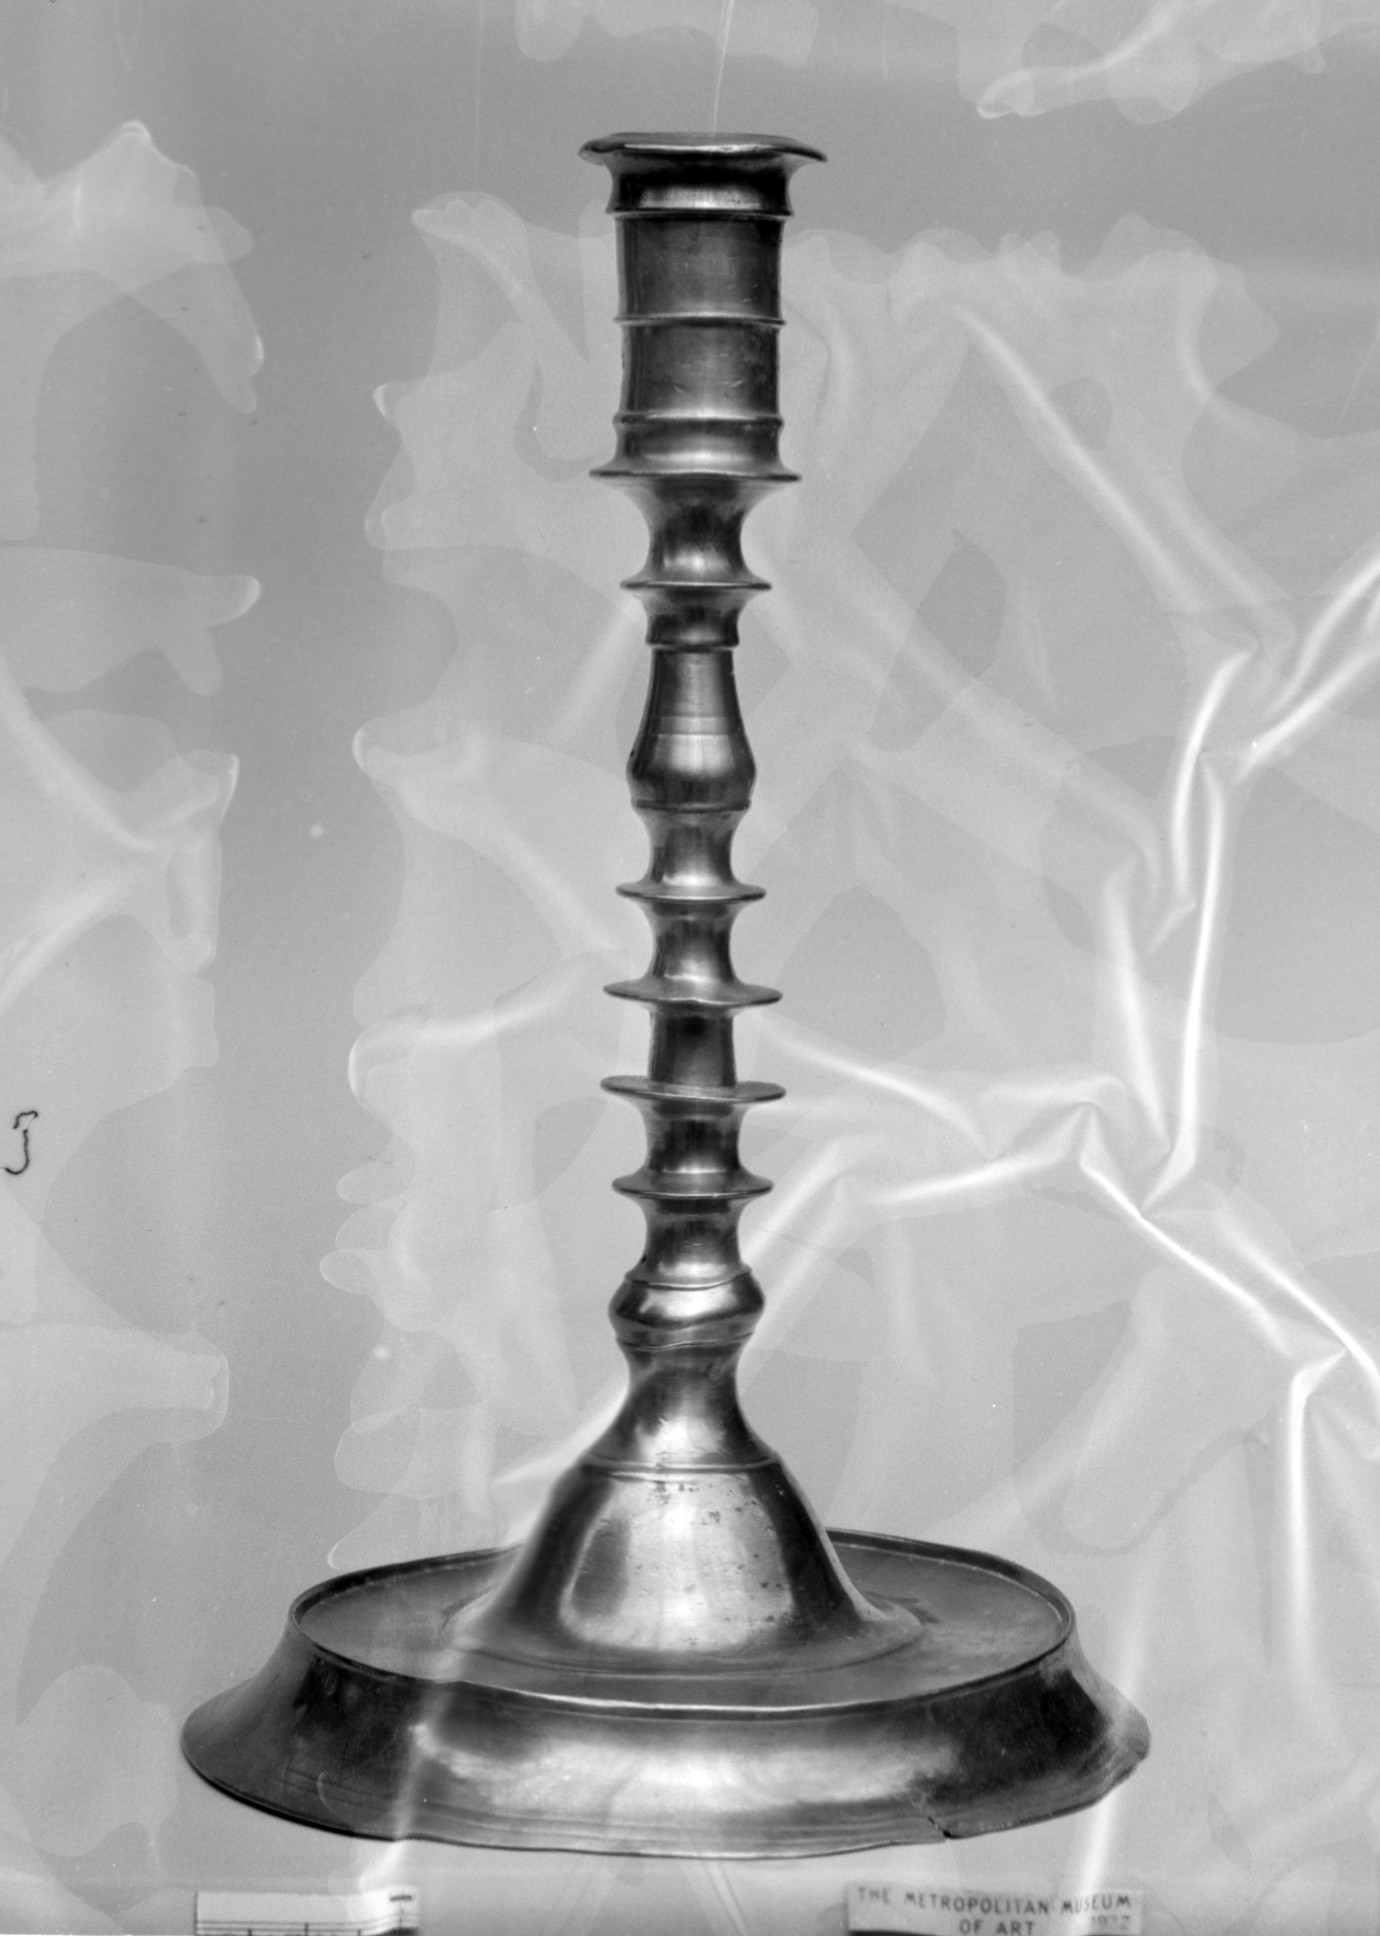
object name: candlestick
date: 1501-1600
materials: brass